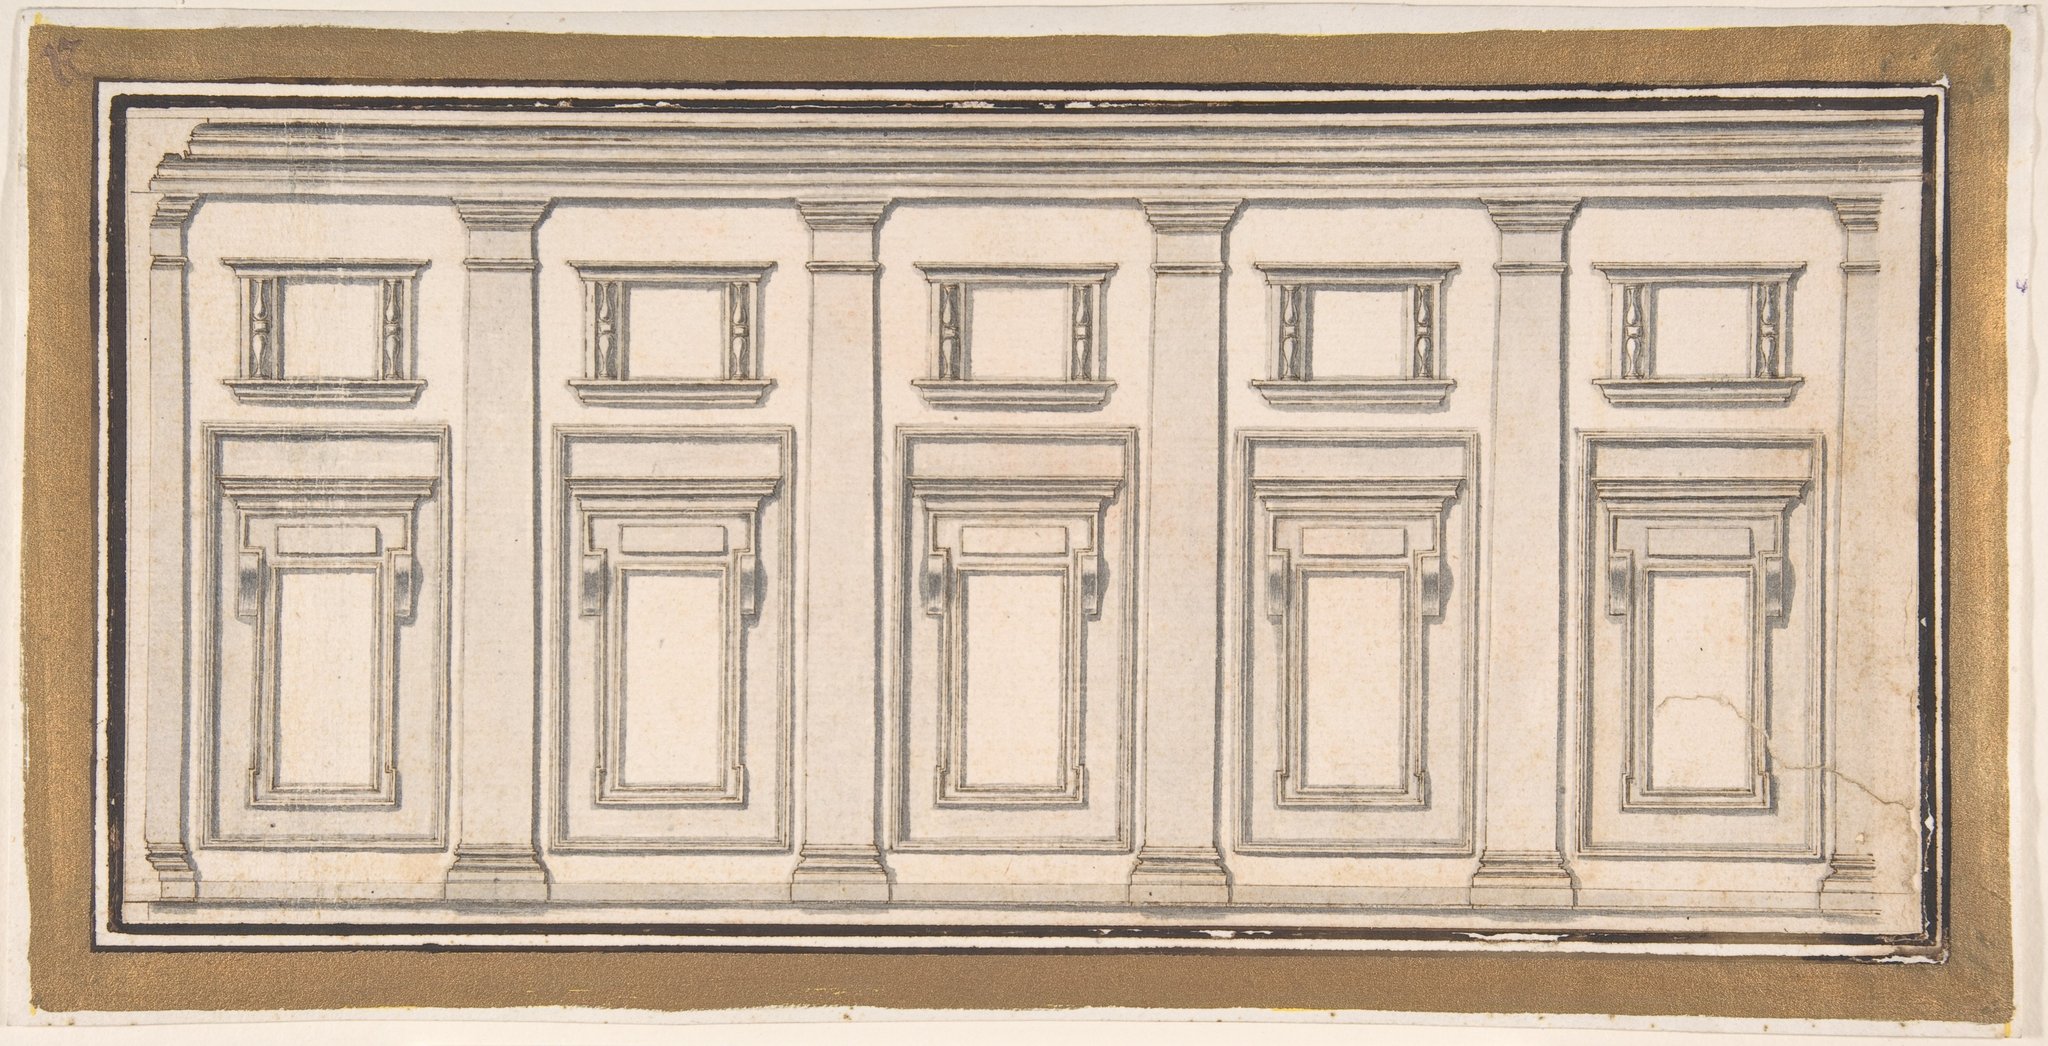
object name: drawing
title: Design for a Wall Elevation with Five Bays in the Doric Order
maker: anonymous, italian, 17th century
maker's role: artist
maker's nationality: italian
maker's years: 1600-1700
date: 1601-1700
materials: ink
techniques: brush, pen, wash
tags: architecture